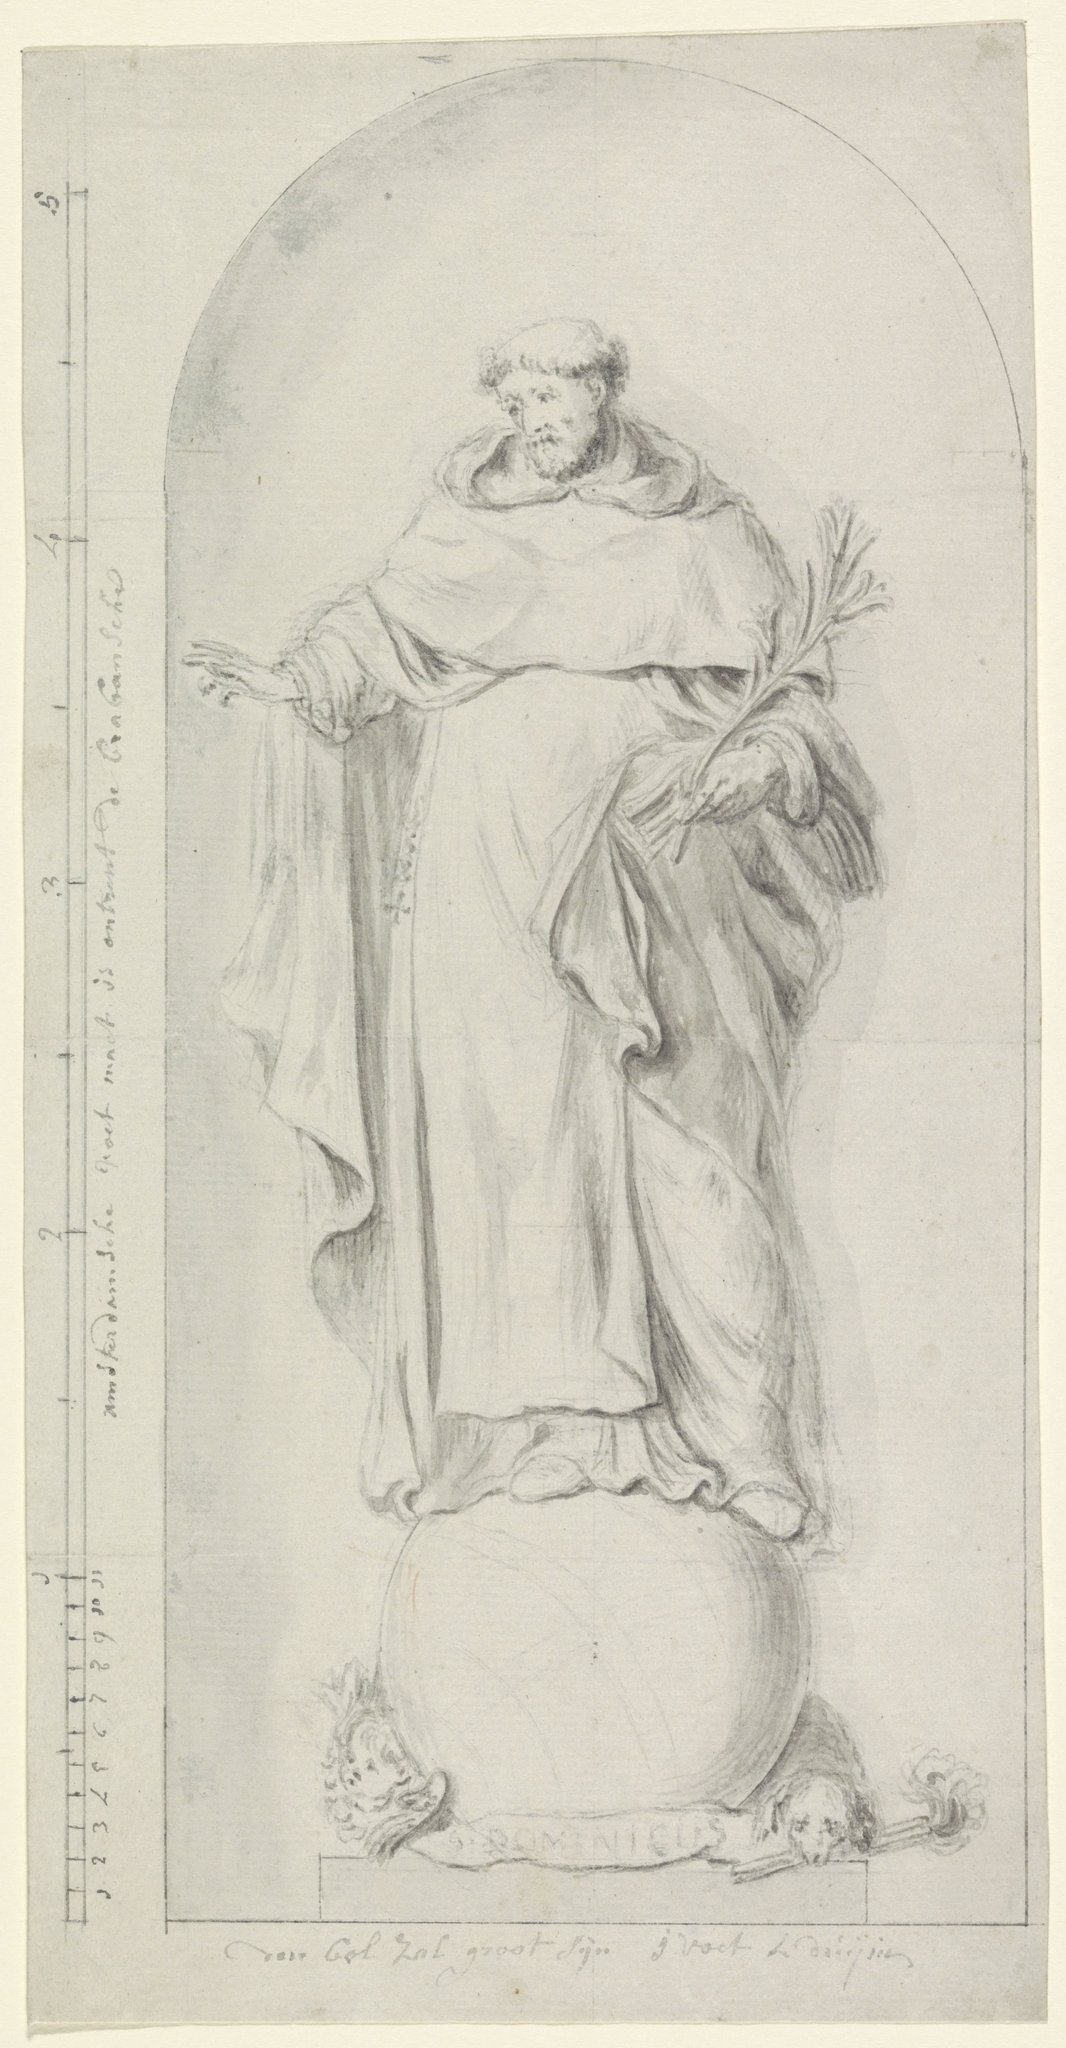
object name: drawing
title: Sint Dominicus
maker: Anonymous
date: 1700-1800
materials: ink, paper, pencil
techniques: brush, pen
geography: netherlands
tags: dominic(us) guzman of calerueja, founder of the order of preachers (or dominican (black) friars; possible attributes: book, dog with flaming torch, lily, loaf of bread, rosary, star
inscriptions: collector's mark: Lugt 2228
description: Beeld van Sint Dominicus op een globe met een cherubijn, een hond met een fakkel en een banderol. In de ondermarge de tekst dees bol zal groot sijn.